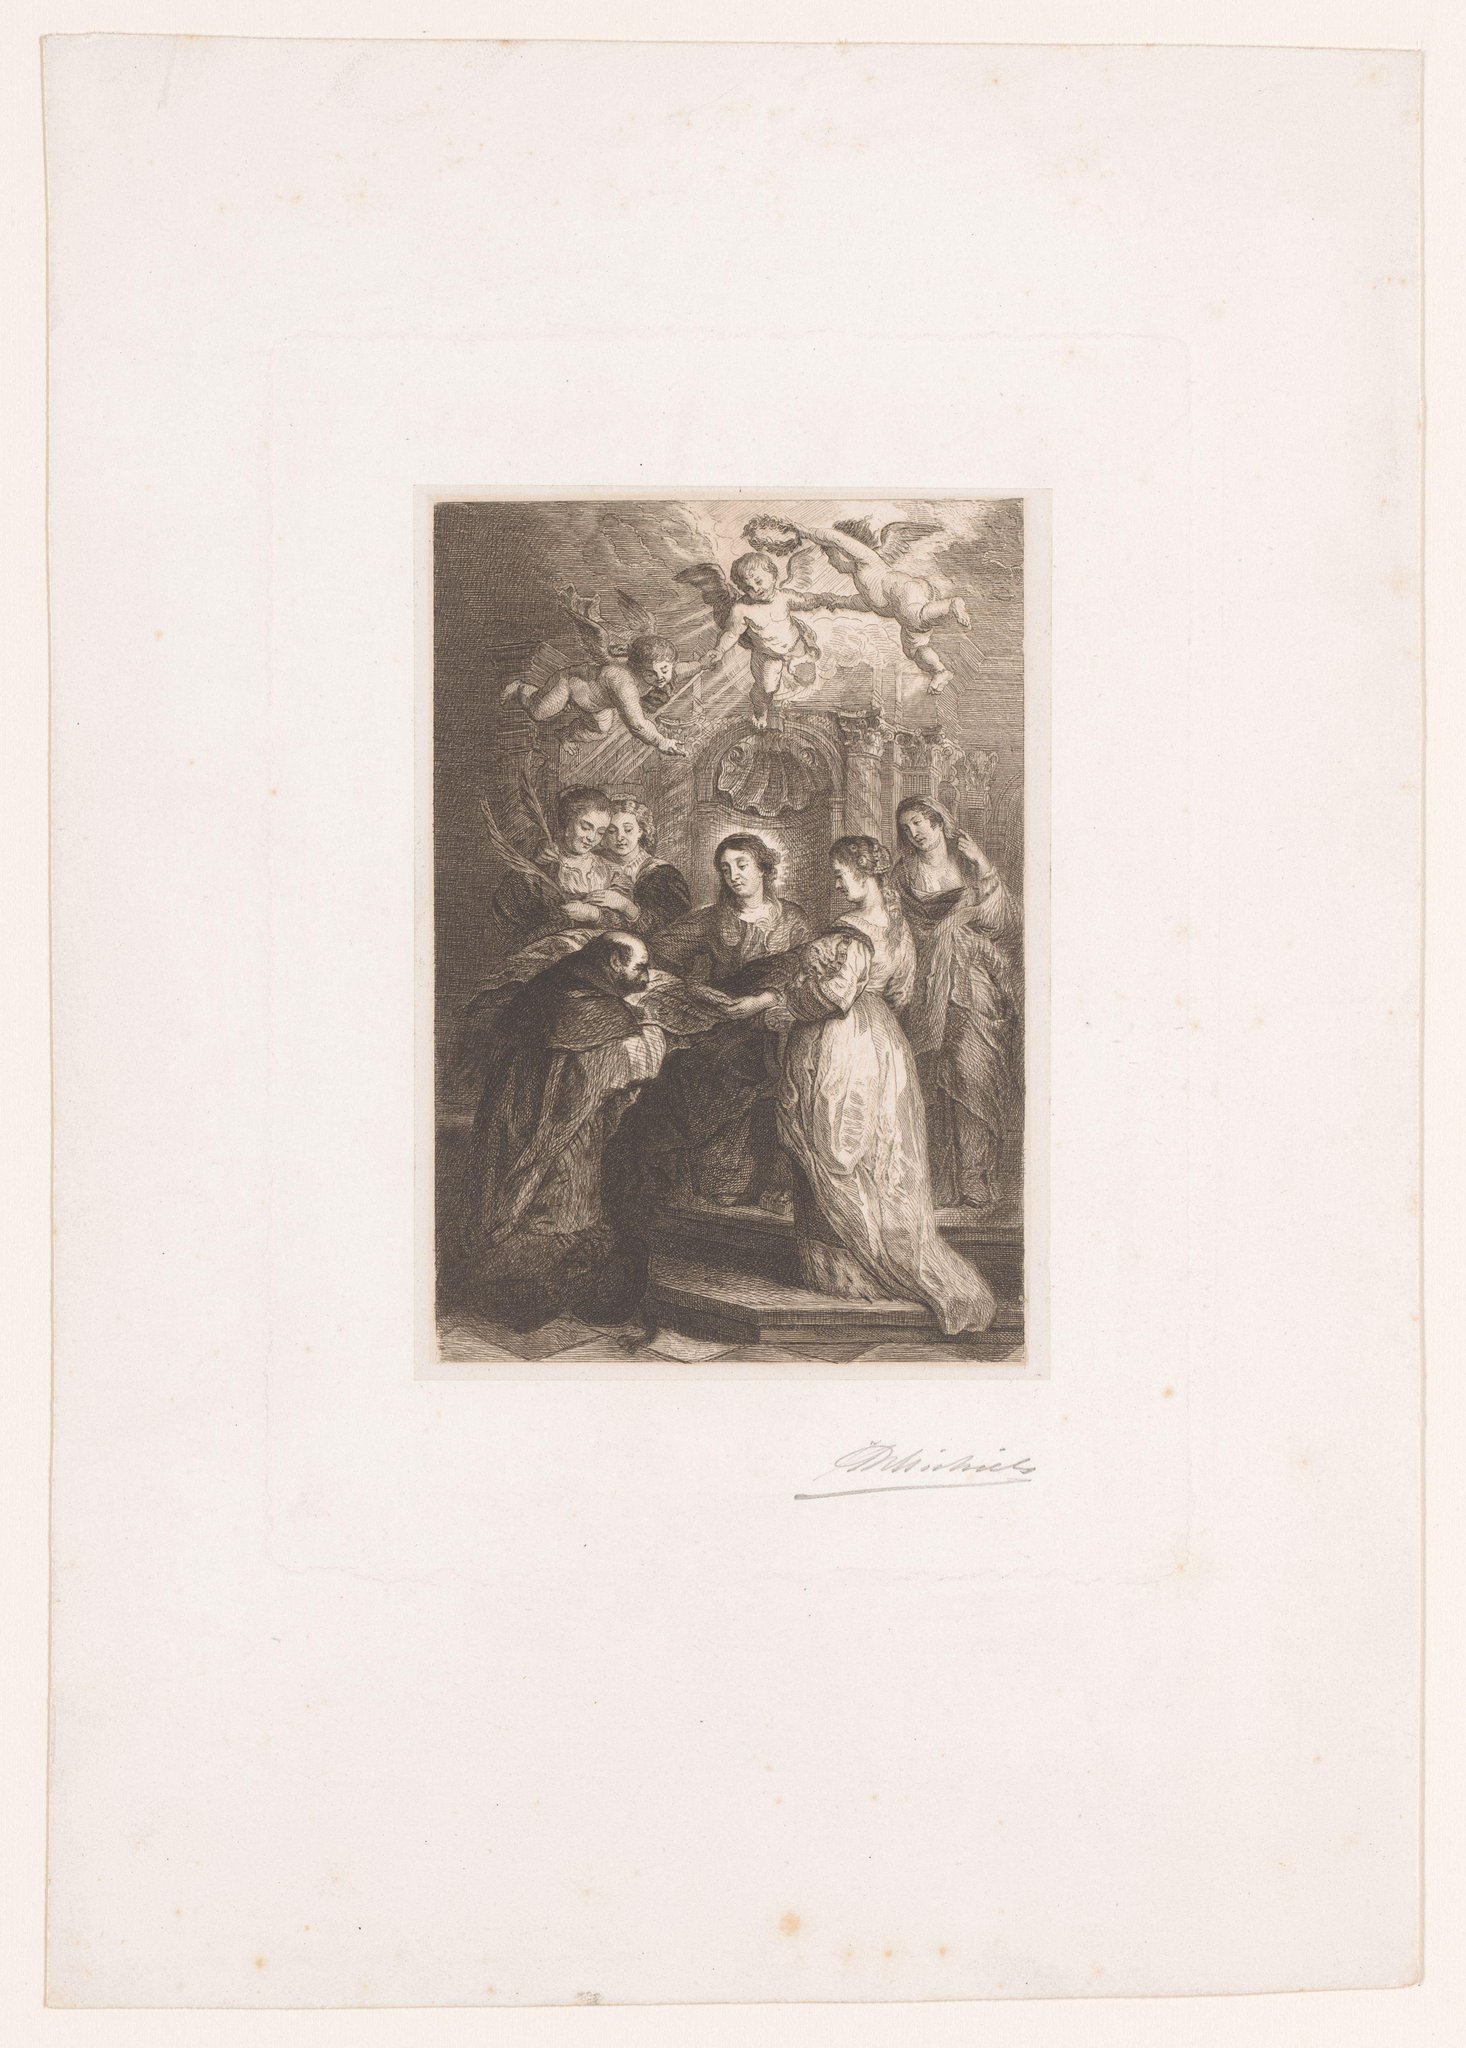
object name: print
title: Sint-Ildefonsus ontvangt een kazuifel van Maria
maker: jean baptiste pierre michiels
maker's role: print maker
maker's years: 1821-1890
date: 1831-1890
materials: paper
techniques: etching, intaglio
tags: the virgin mary appears to st. ildefonso and gives him a chasuble, mary enthroned, angel(s) represented as child(ren)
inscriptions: collector's mark: Lugt 2228